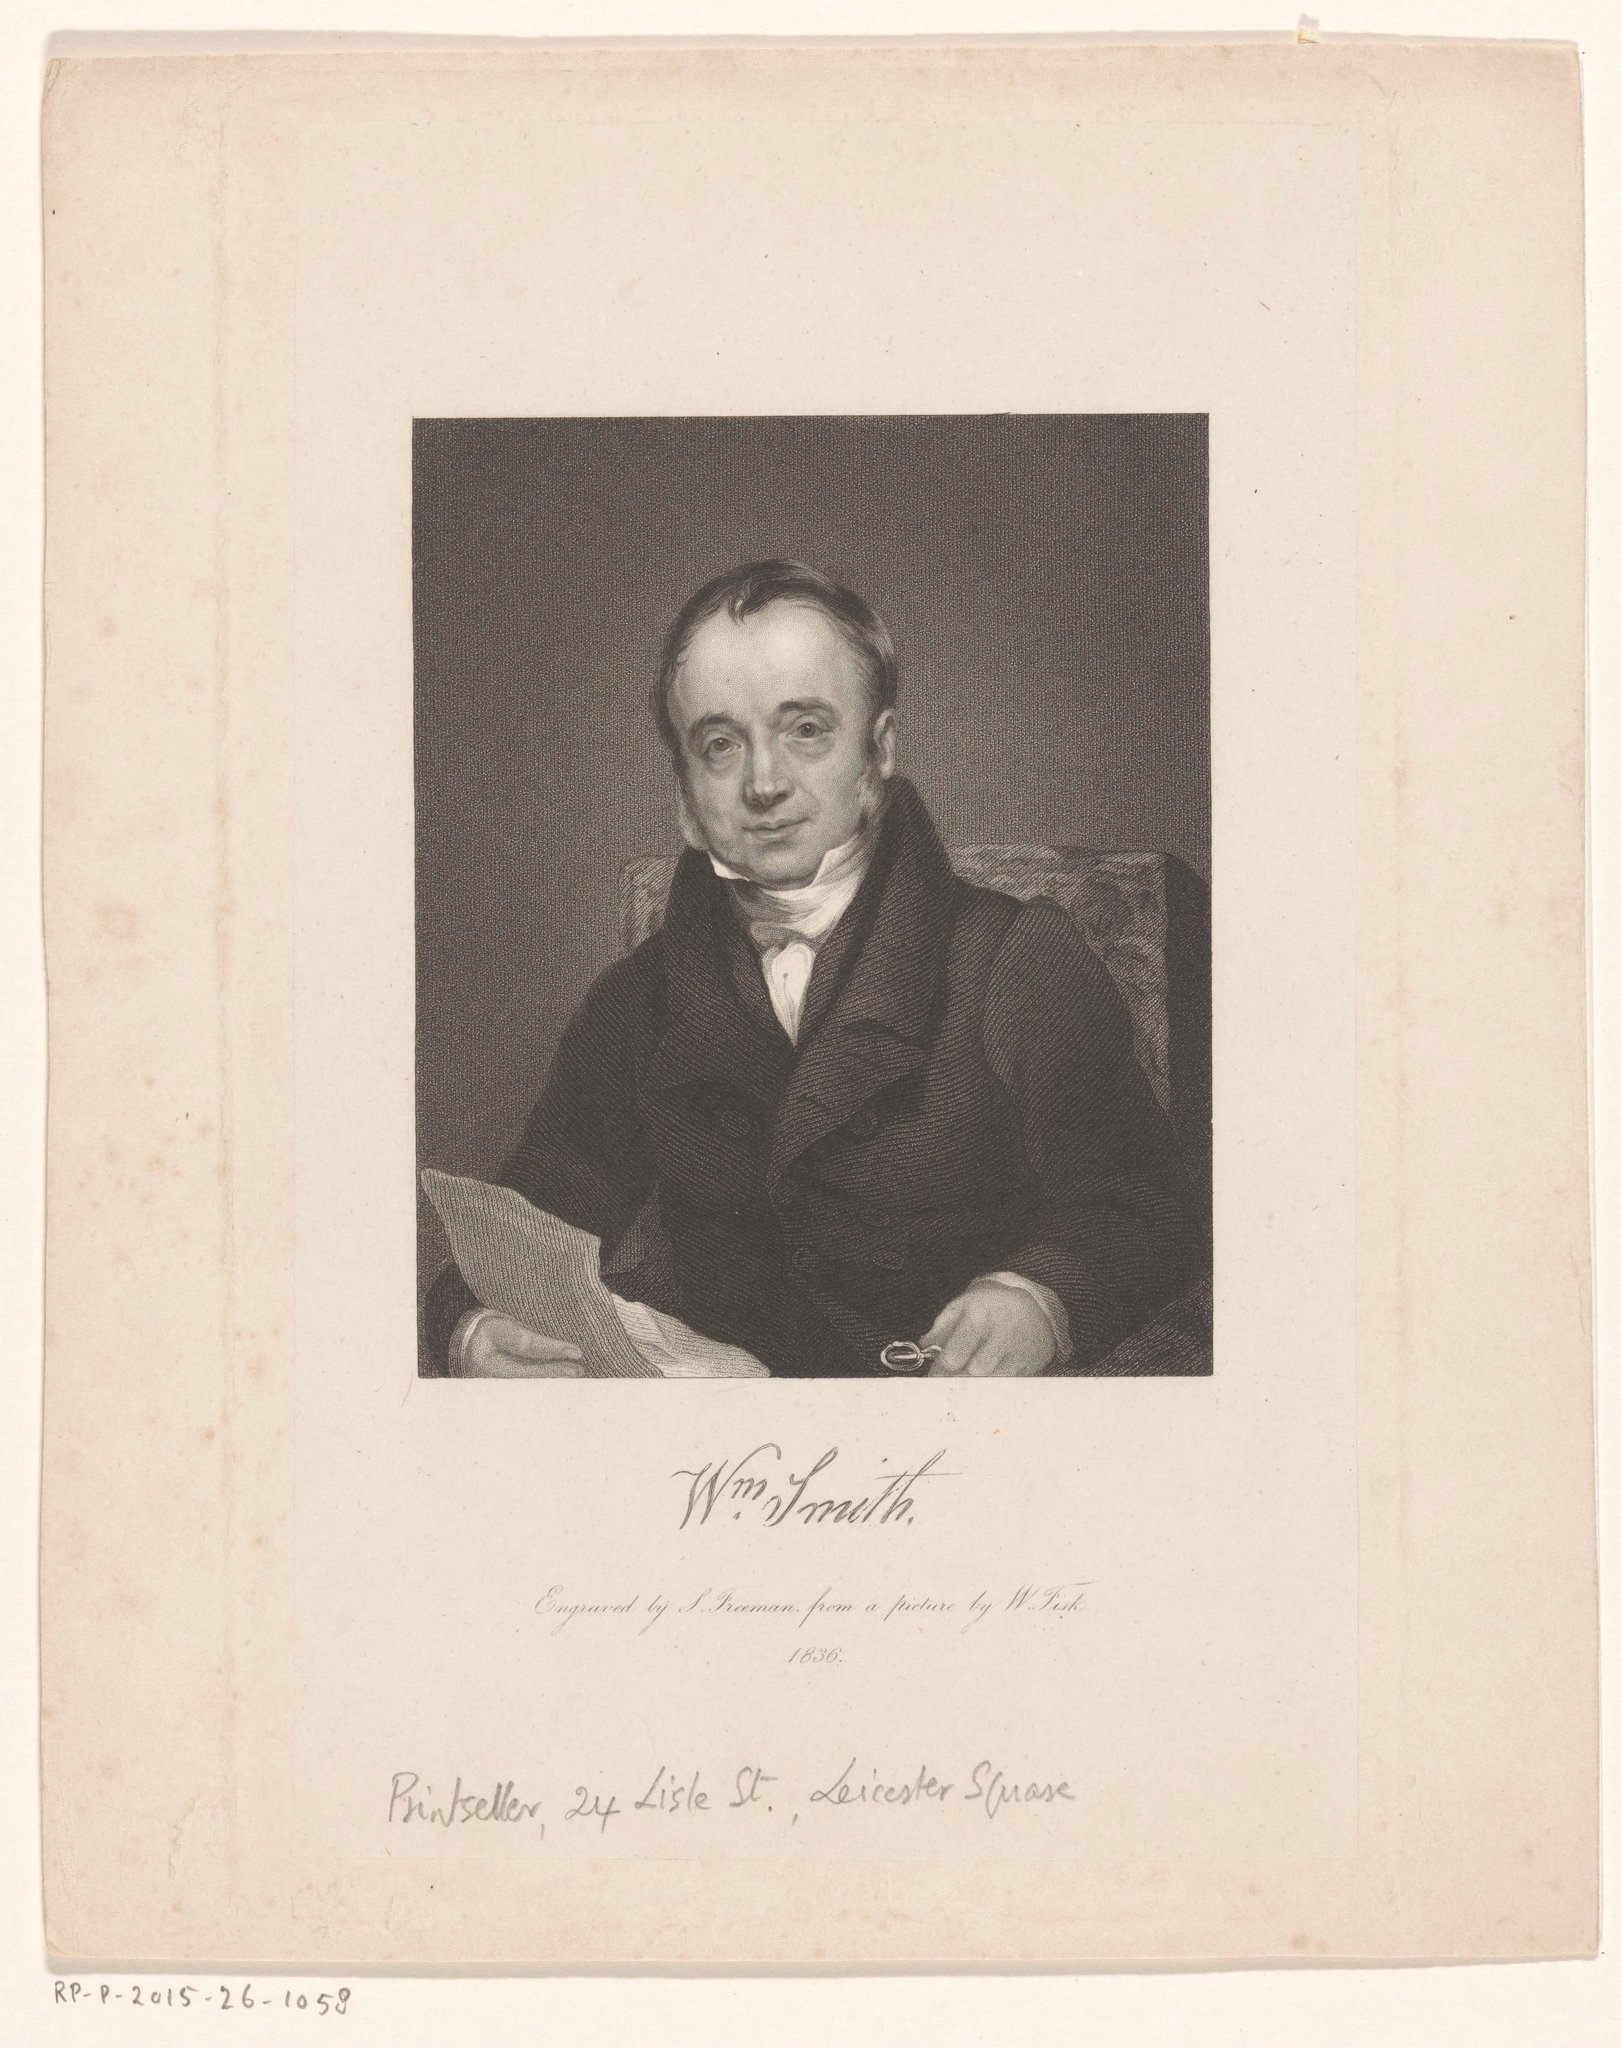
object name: print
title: Portret van William Smith, prentverkoper te Londen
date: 1836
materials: paper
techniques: etching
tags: antique dealer (+ graphic arts)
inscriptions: collector's mark: Lugt 4779, collector's mark: Lugt 2228